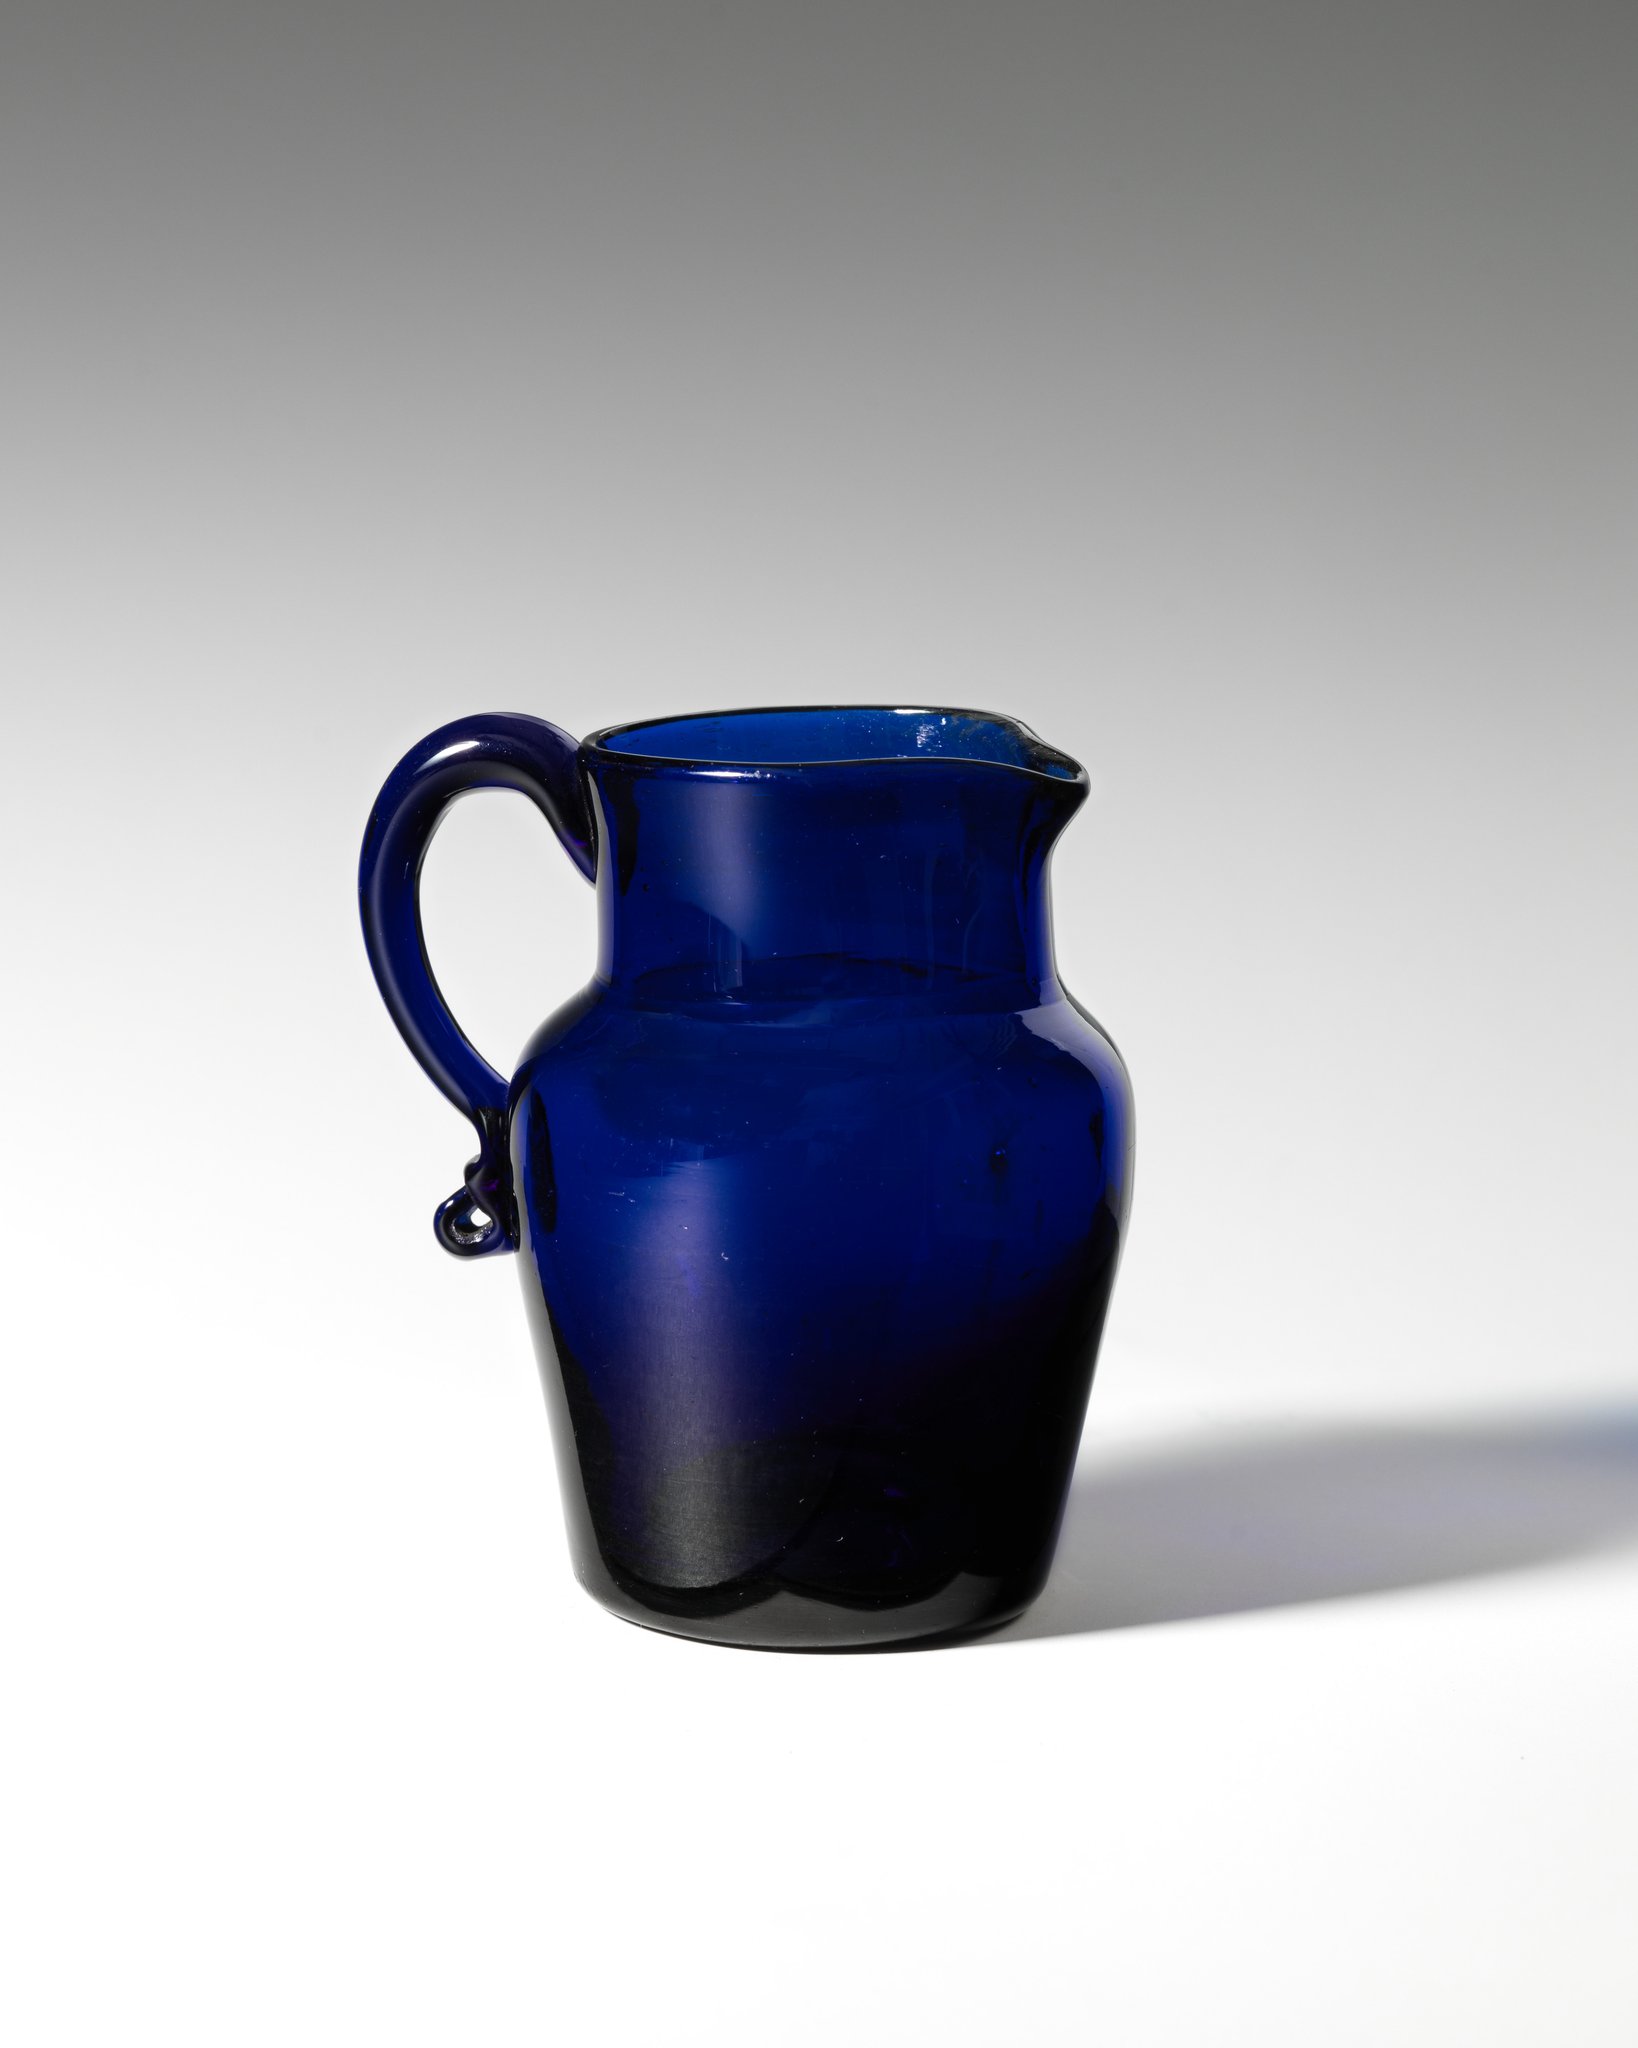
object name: milk jug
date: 1750-1800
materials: glass